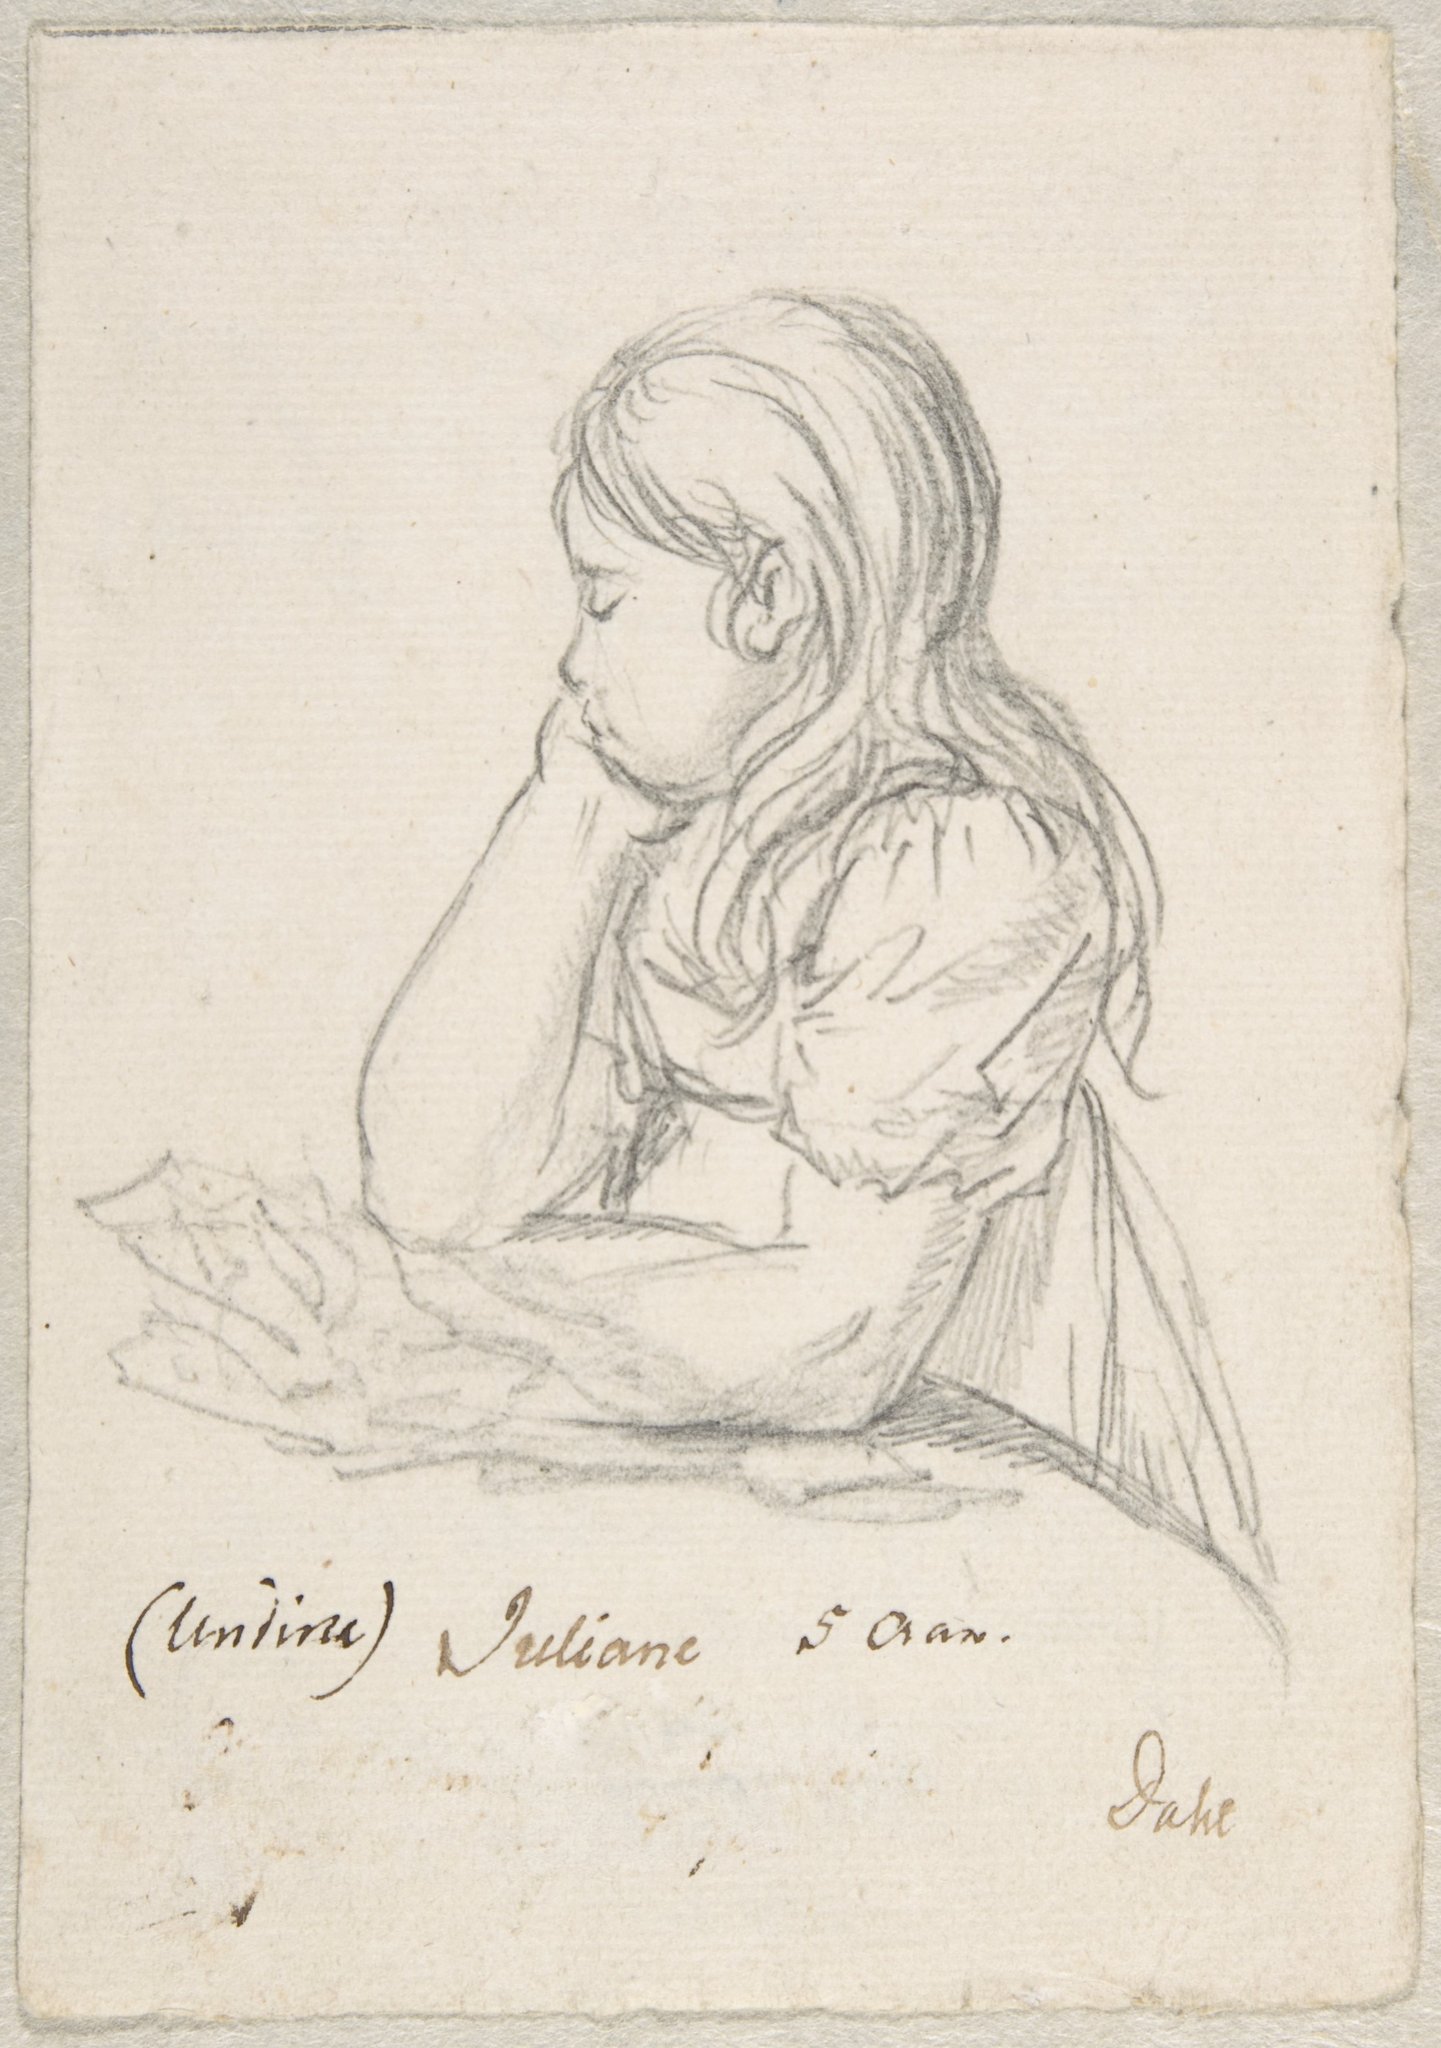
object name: drawing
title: Portrait of Juliane Sophie Heger as a Child, leaning on a Table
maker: johan christian dahl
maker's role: artist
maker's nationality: norwegian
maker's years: 1788-1857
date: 1820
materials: graphite, ink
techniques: pen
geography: norway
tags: girls